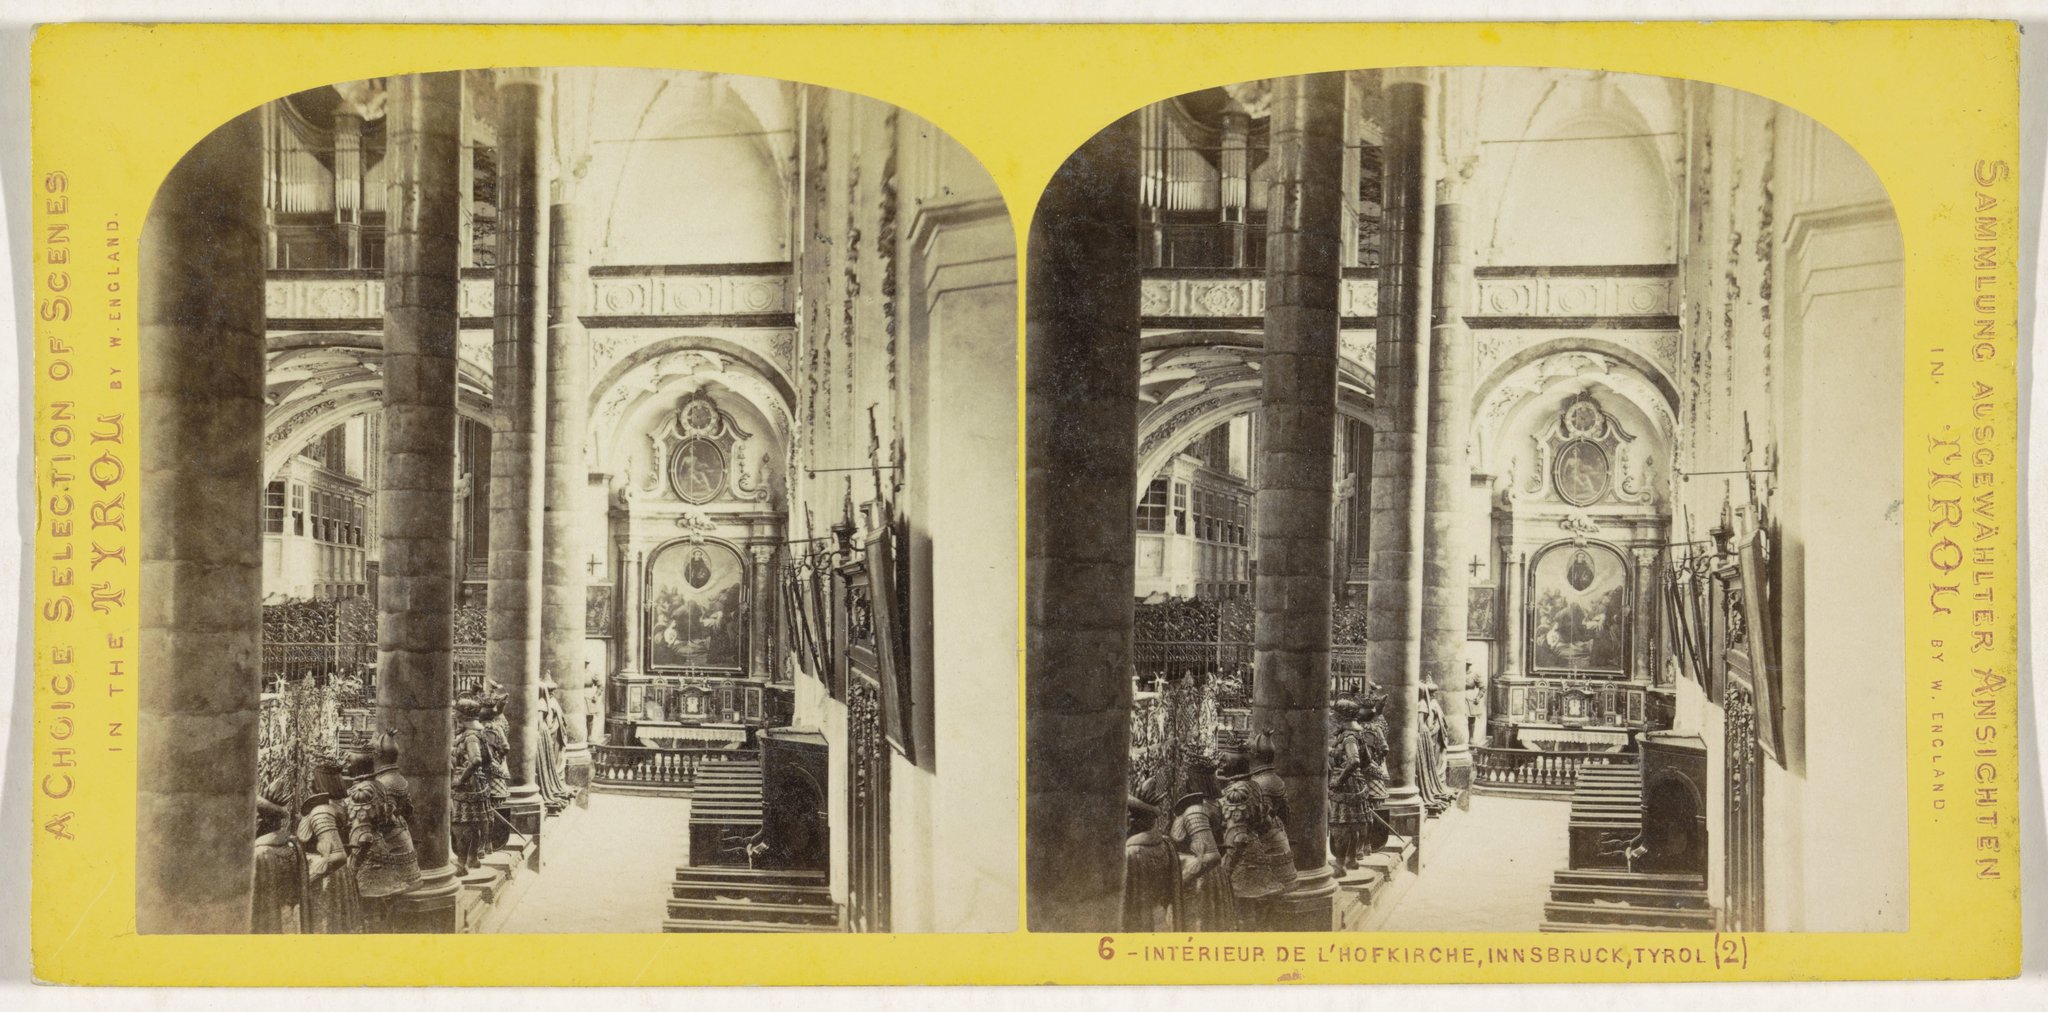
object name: stereograph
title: Interieur van de Hofkerk in Innsbruck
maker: william england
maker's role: fotograaf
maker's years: 1816-1896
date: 1863-1865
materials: cardboard, paper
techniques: albumen print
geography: innsbruck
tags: interior of church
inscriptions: number: ‘6’